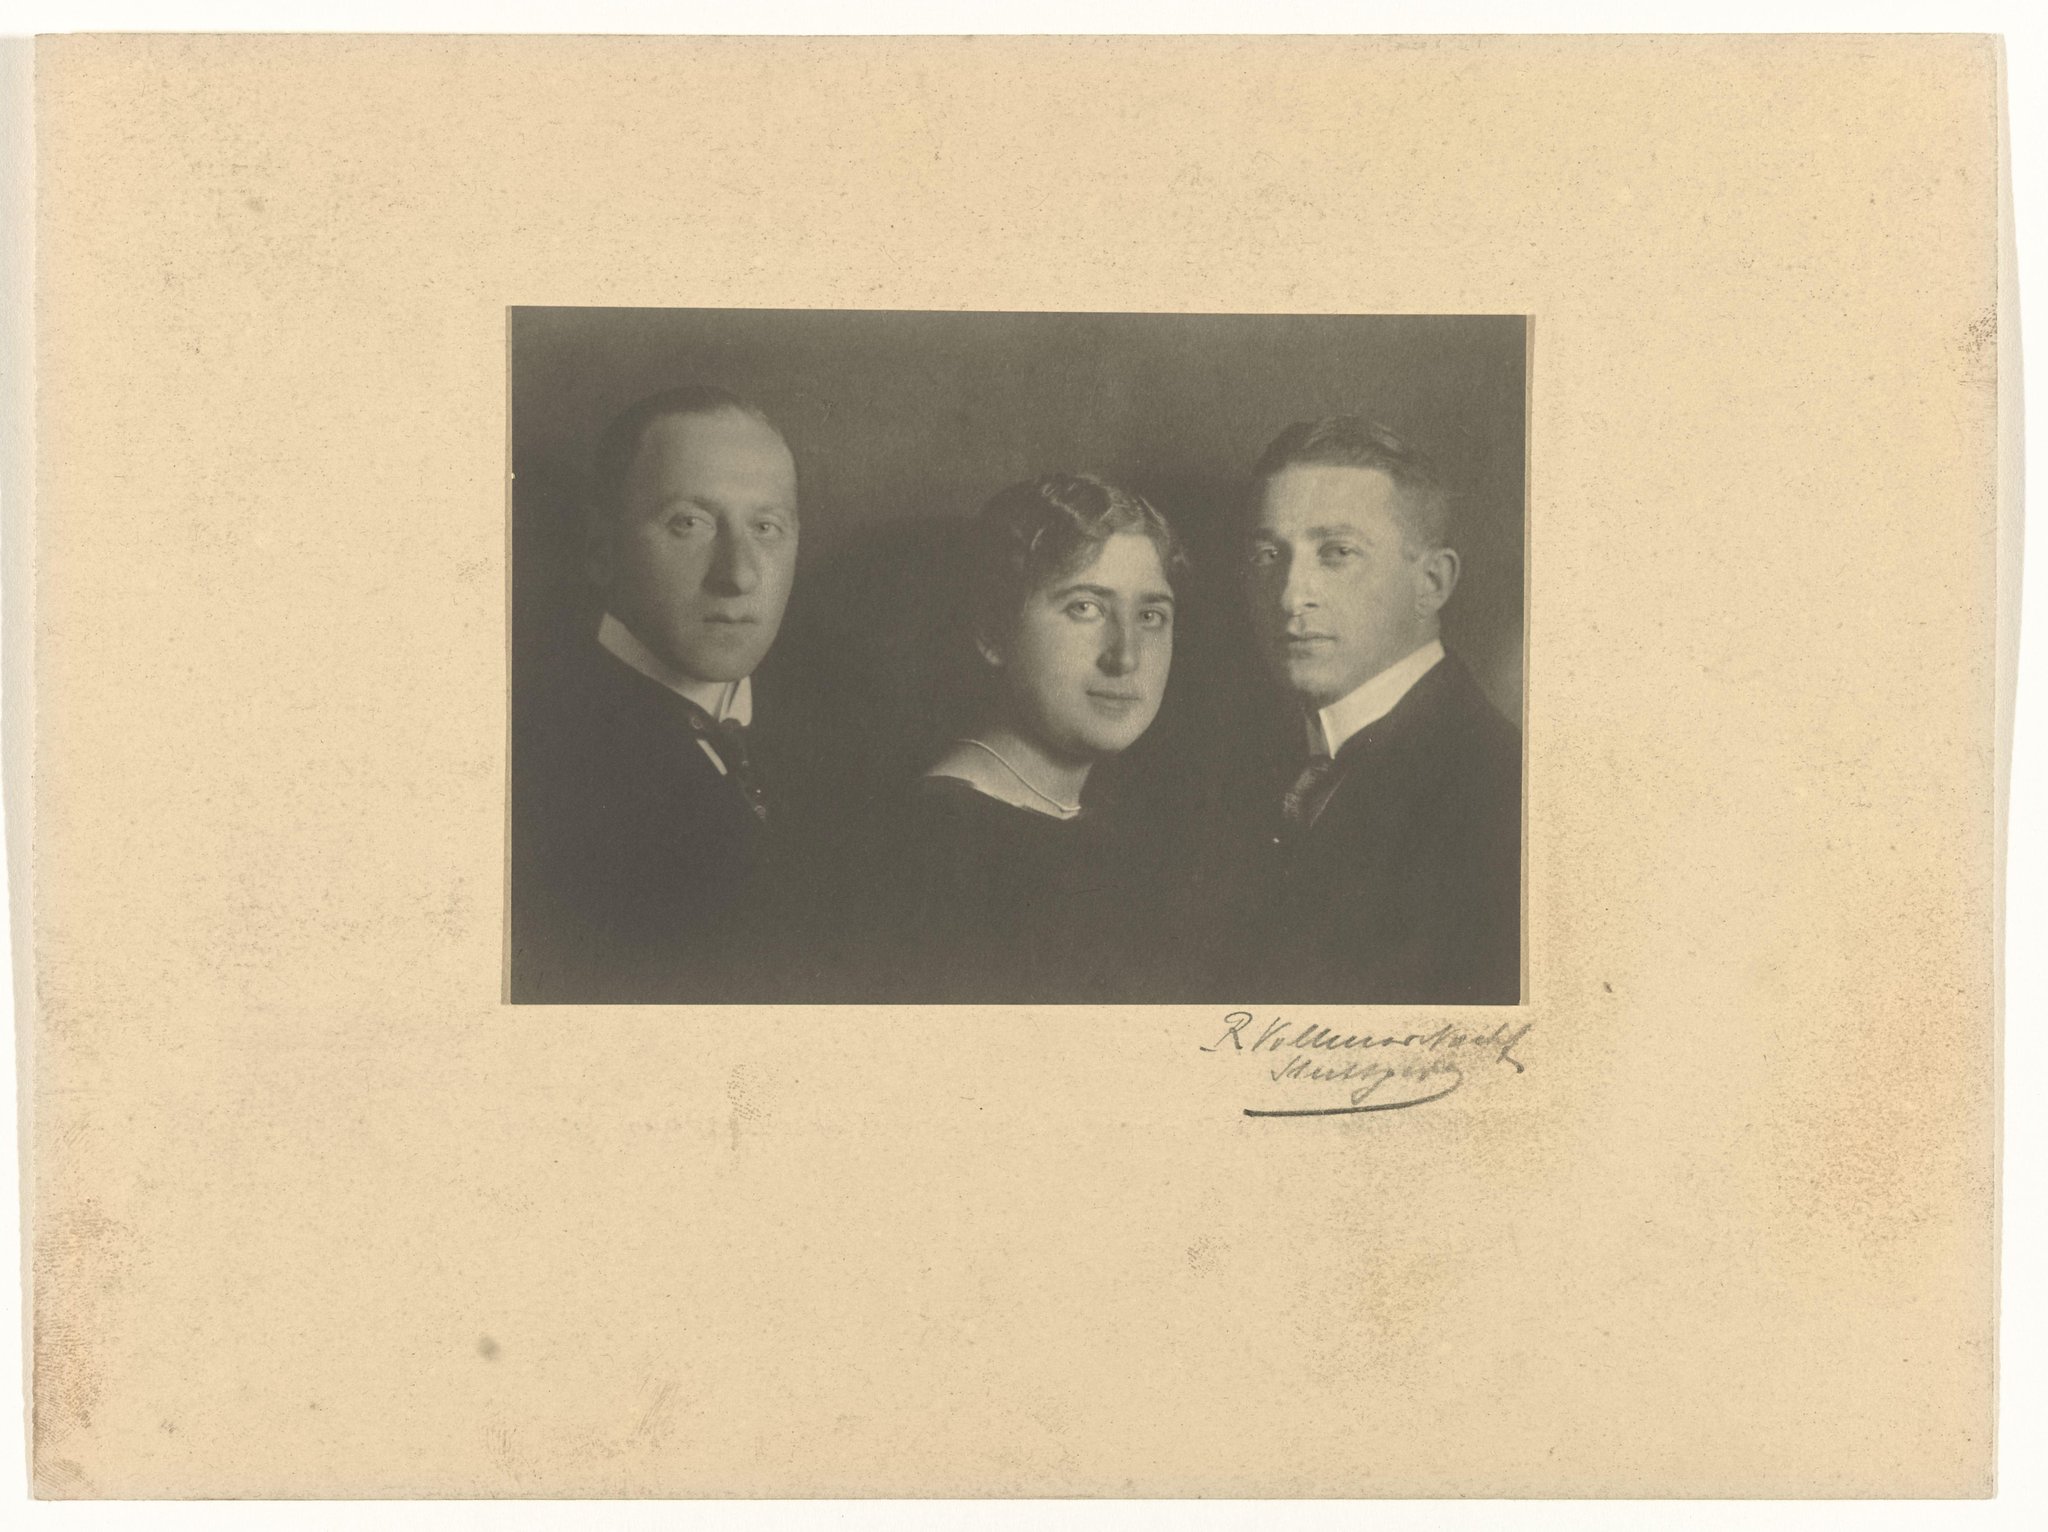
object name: photograph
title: Vooraanzicht van Arthur Moos (links), Else Wachenheimer-Moos (midden) en Willy Moos (rechts), Stuttgart, 1913-1922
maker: Anonymous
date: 1913-1922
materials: photographic support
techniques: gelatin silver print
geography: stuttgart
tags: else wachenheimer-moos, willy moos, arthur moos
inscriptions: company name: ‘R Vollumernacht Stuttgart’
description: Vooraanzicht van Arthur, Else en Willy Moos.